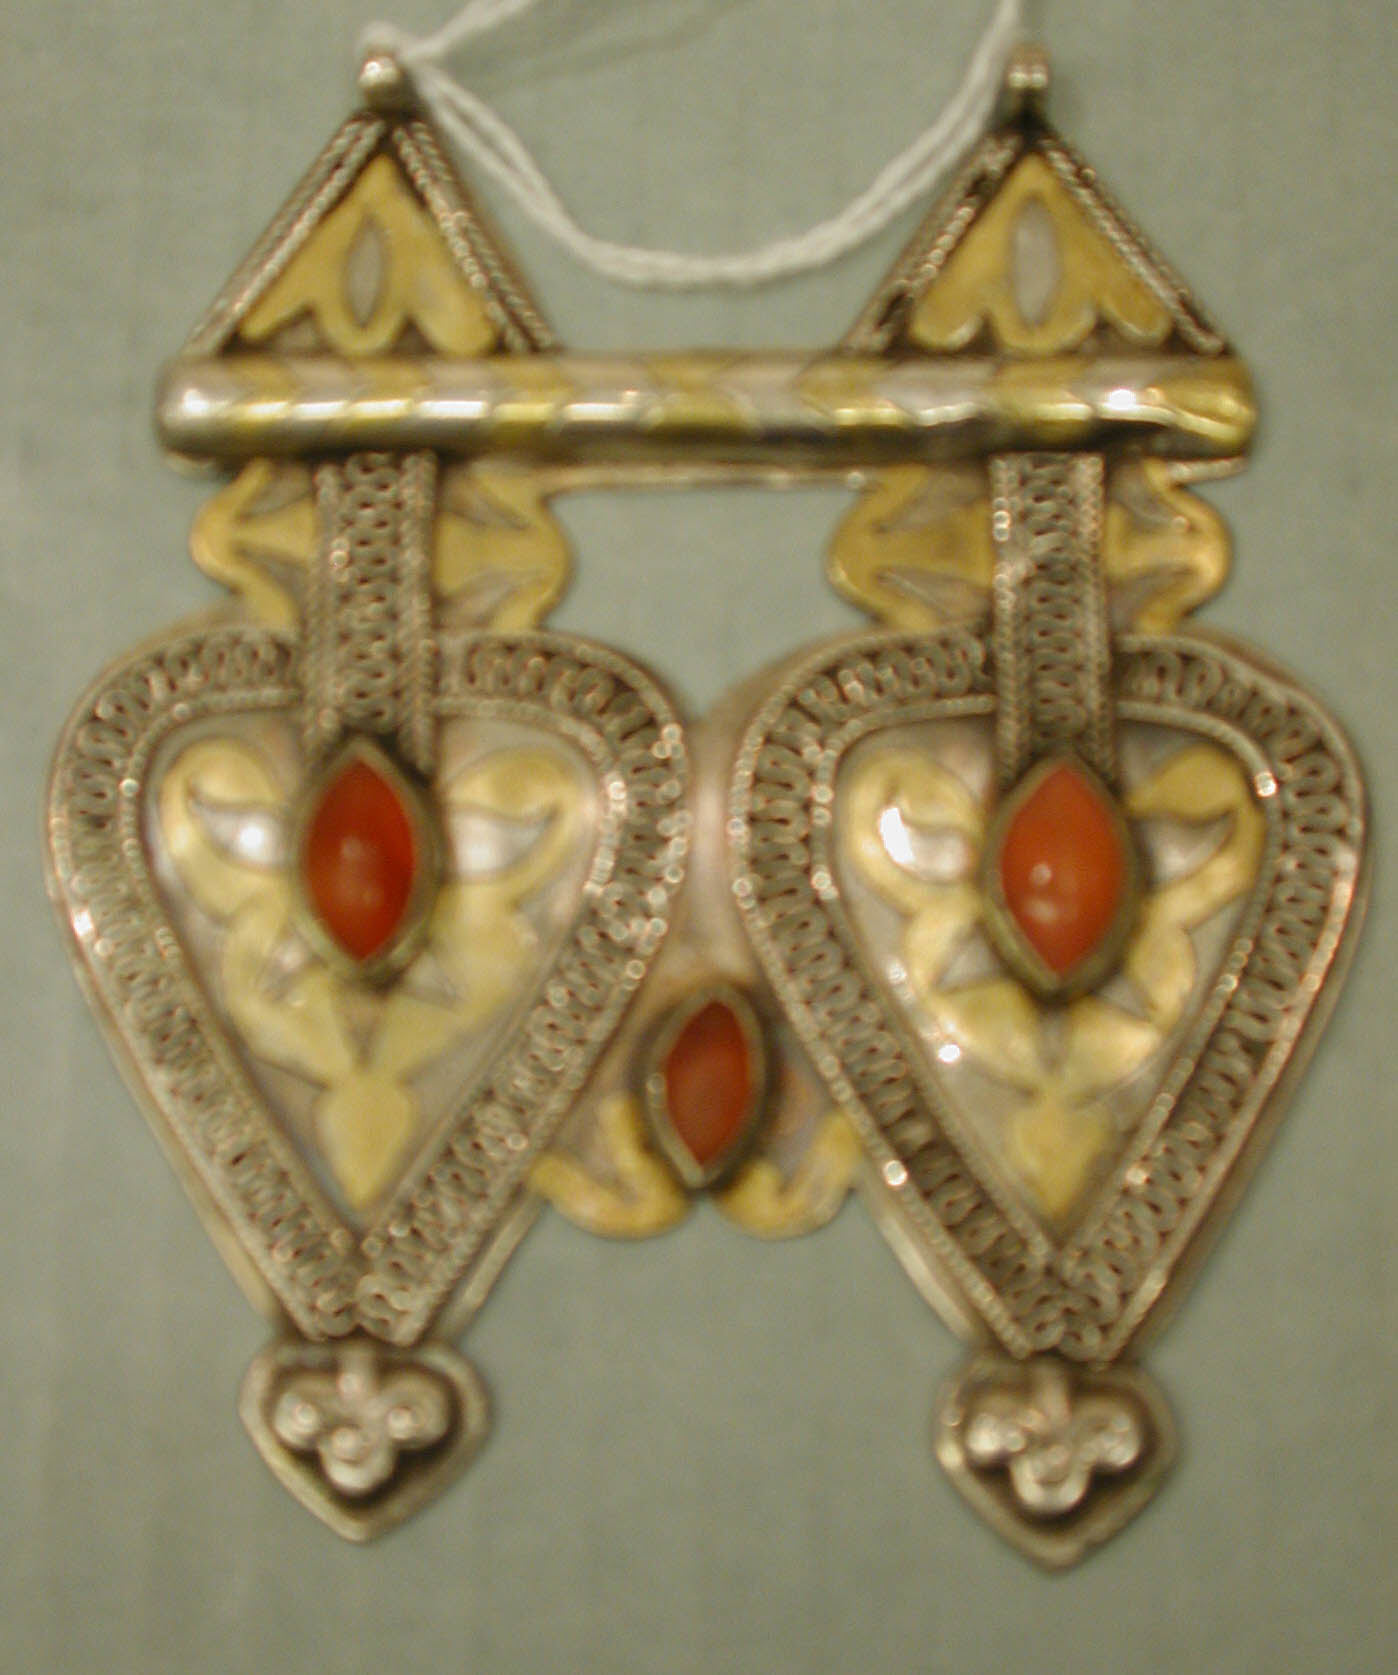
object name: ornament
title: Double Cordiform Pendant, One of a Pair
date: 1867-1933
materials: carnelian, silver, metal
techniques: chasing, embossing, gilding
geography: central asia